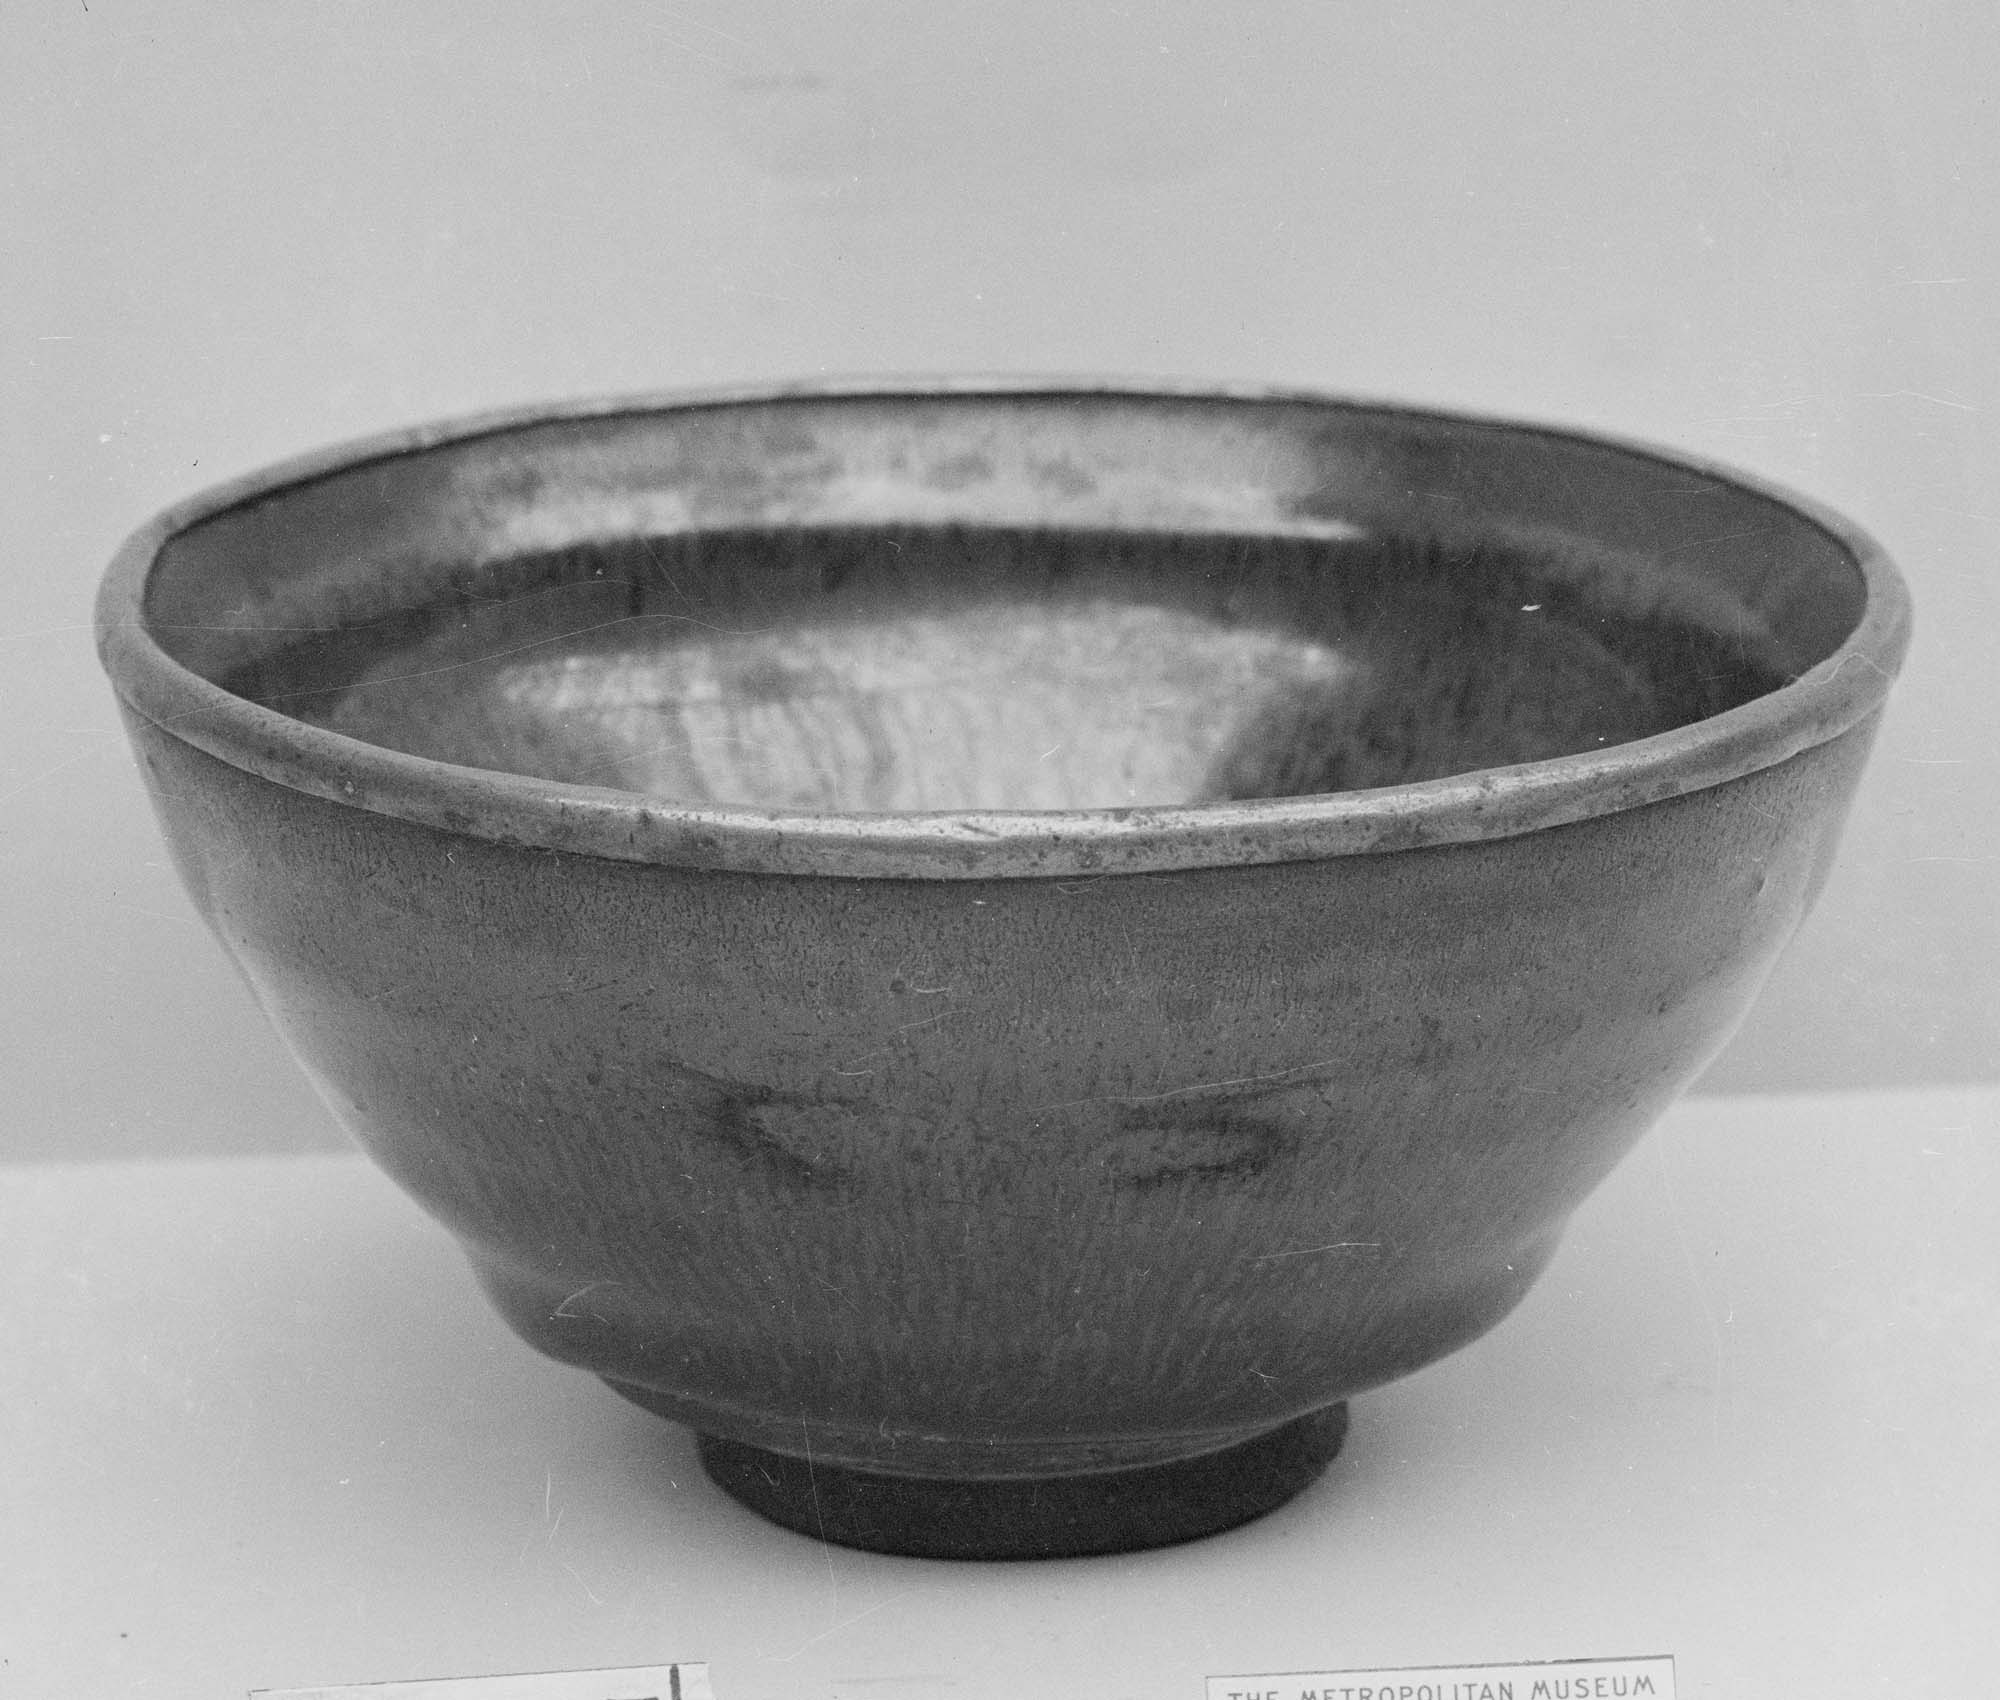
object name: bowl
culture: chinese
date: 960-1279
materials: glaze, metal